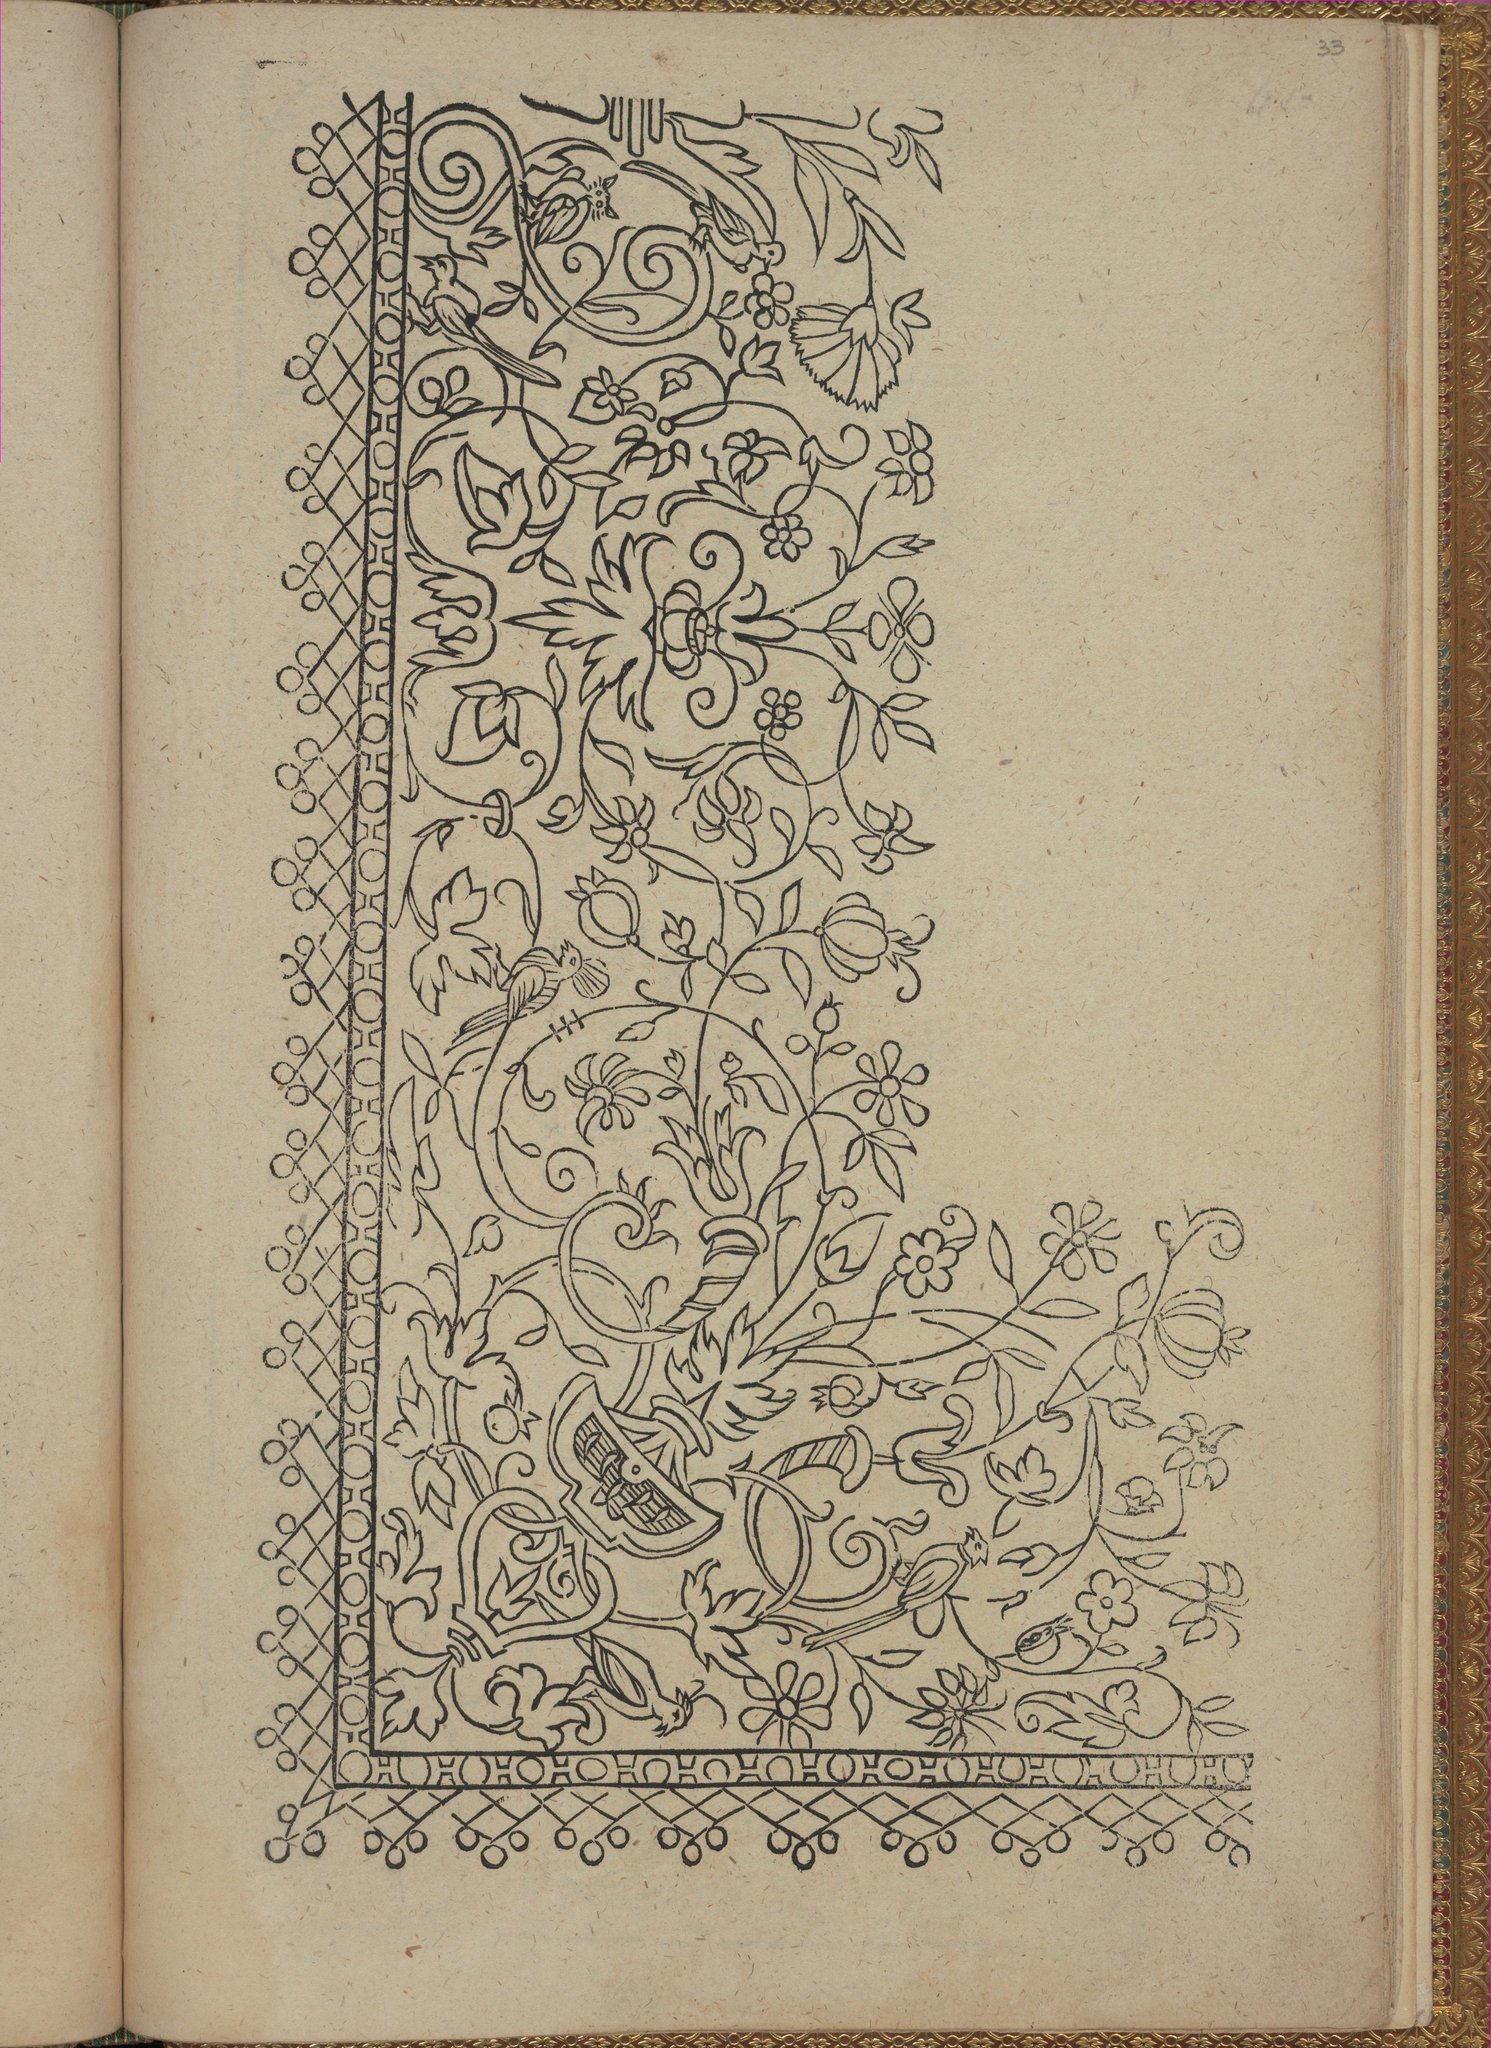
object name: book print ornament architecture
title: New Modelbüch (Page 32r)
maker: andreas bretschneider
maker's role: designer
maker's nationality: german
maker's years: 1573-1645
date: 1615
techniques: woodcut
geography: germany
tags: flowers